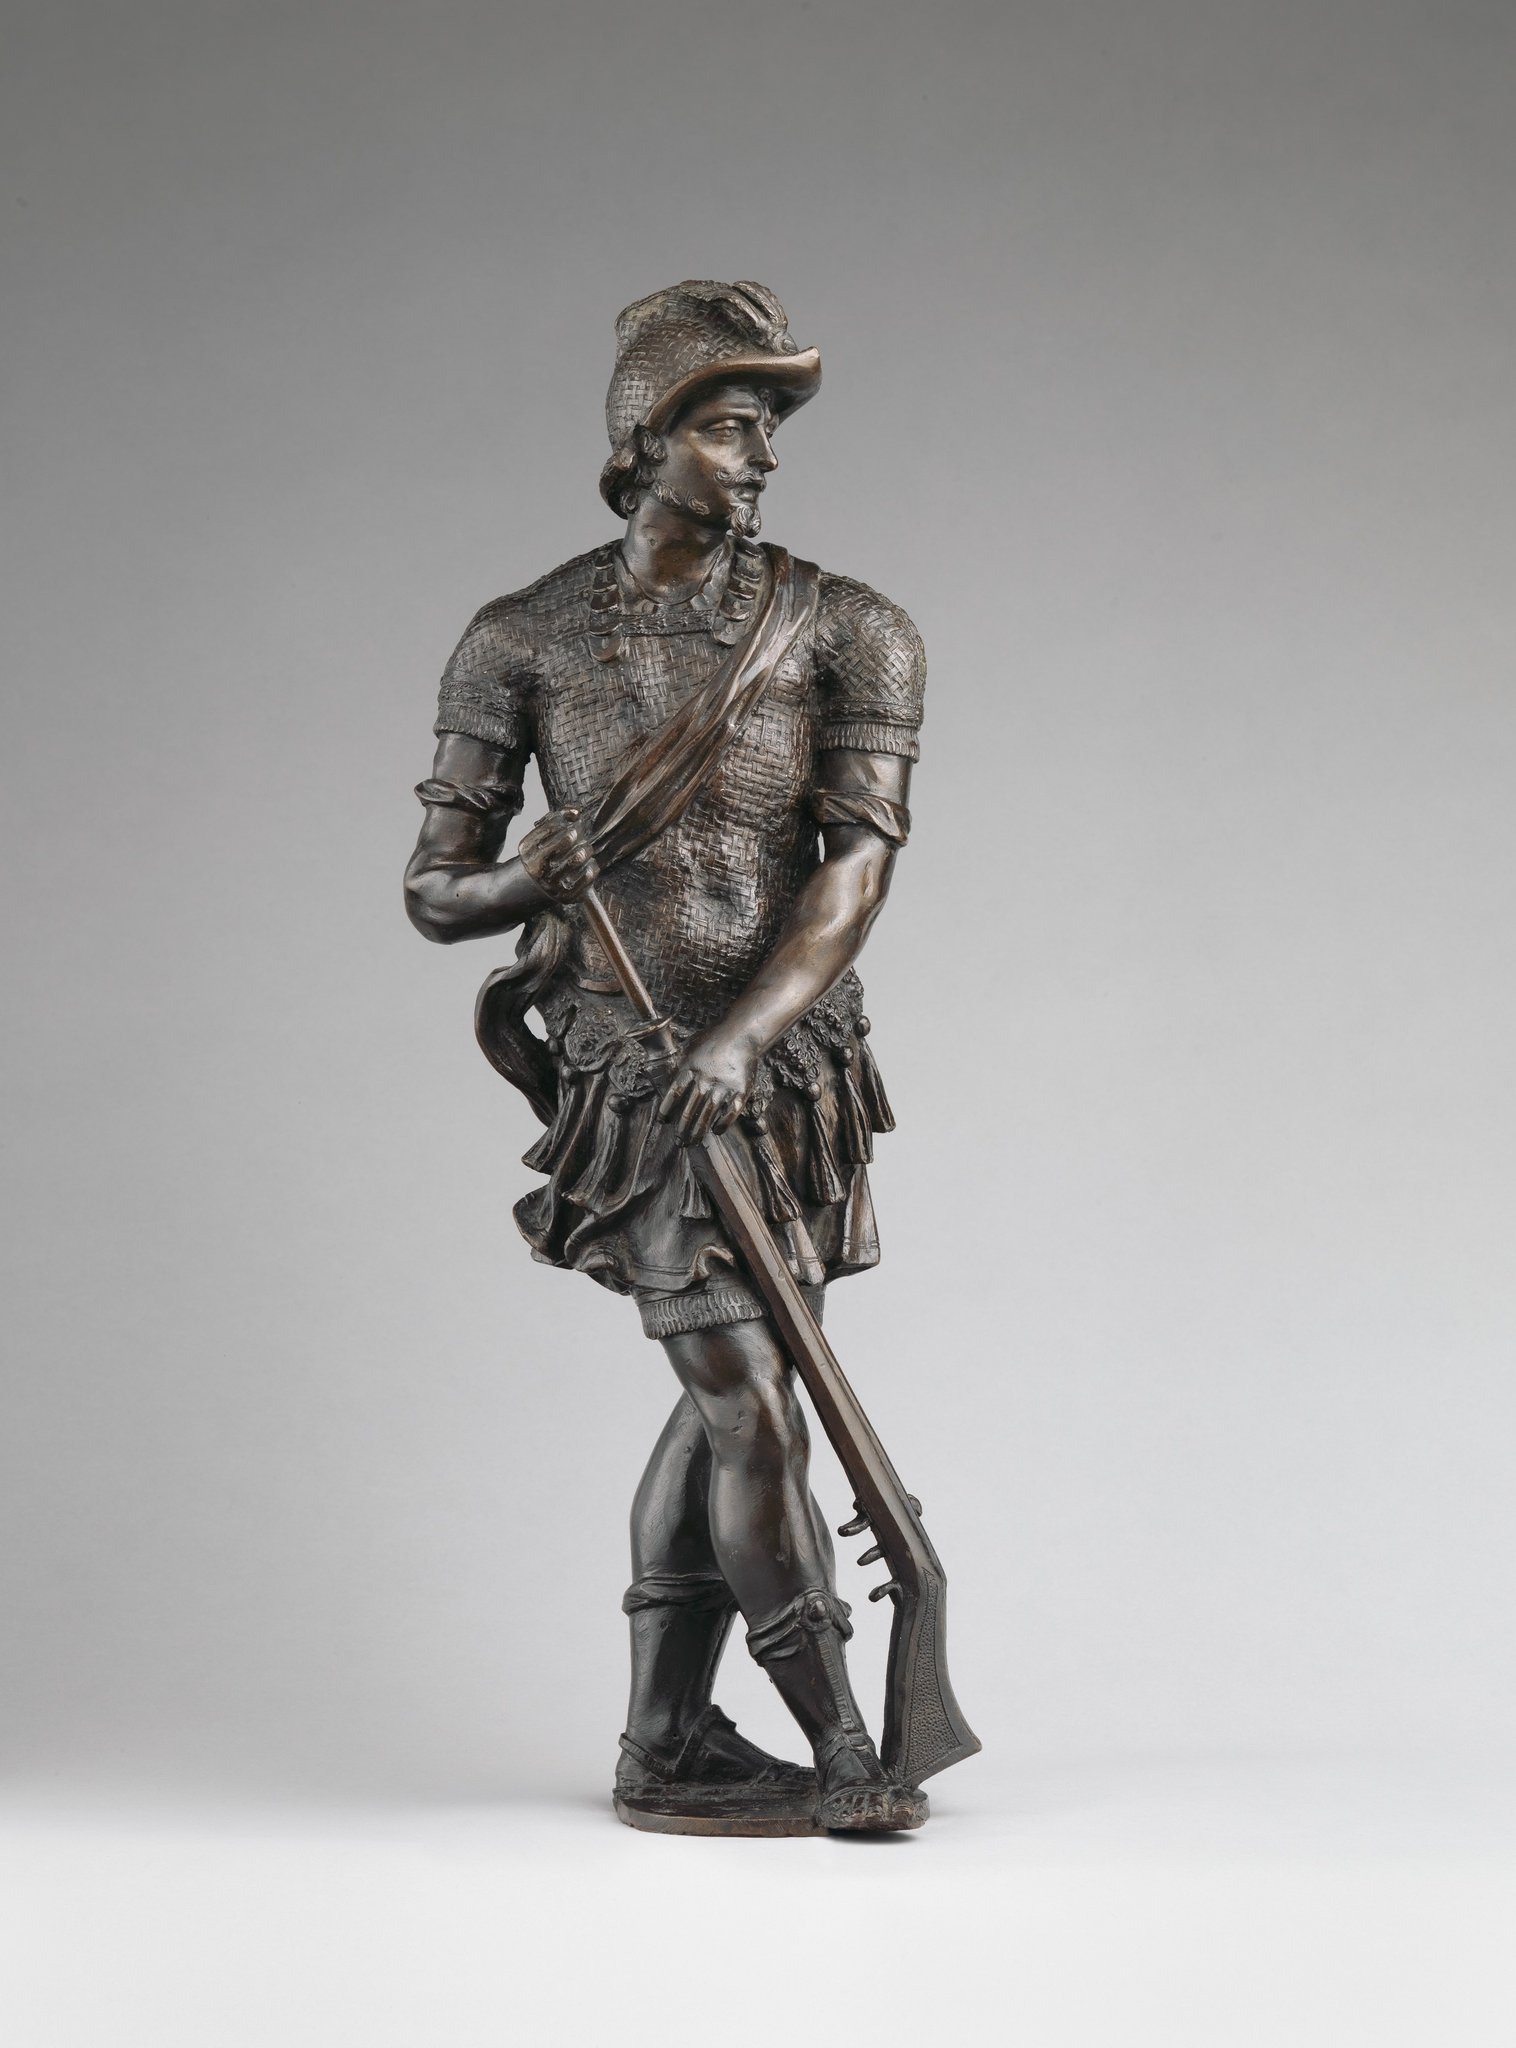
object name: statuette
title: Warrior (Musketeer)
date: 1601-1700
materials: bronze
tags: firearms,mars,warriors